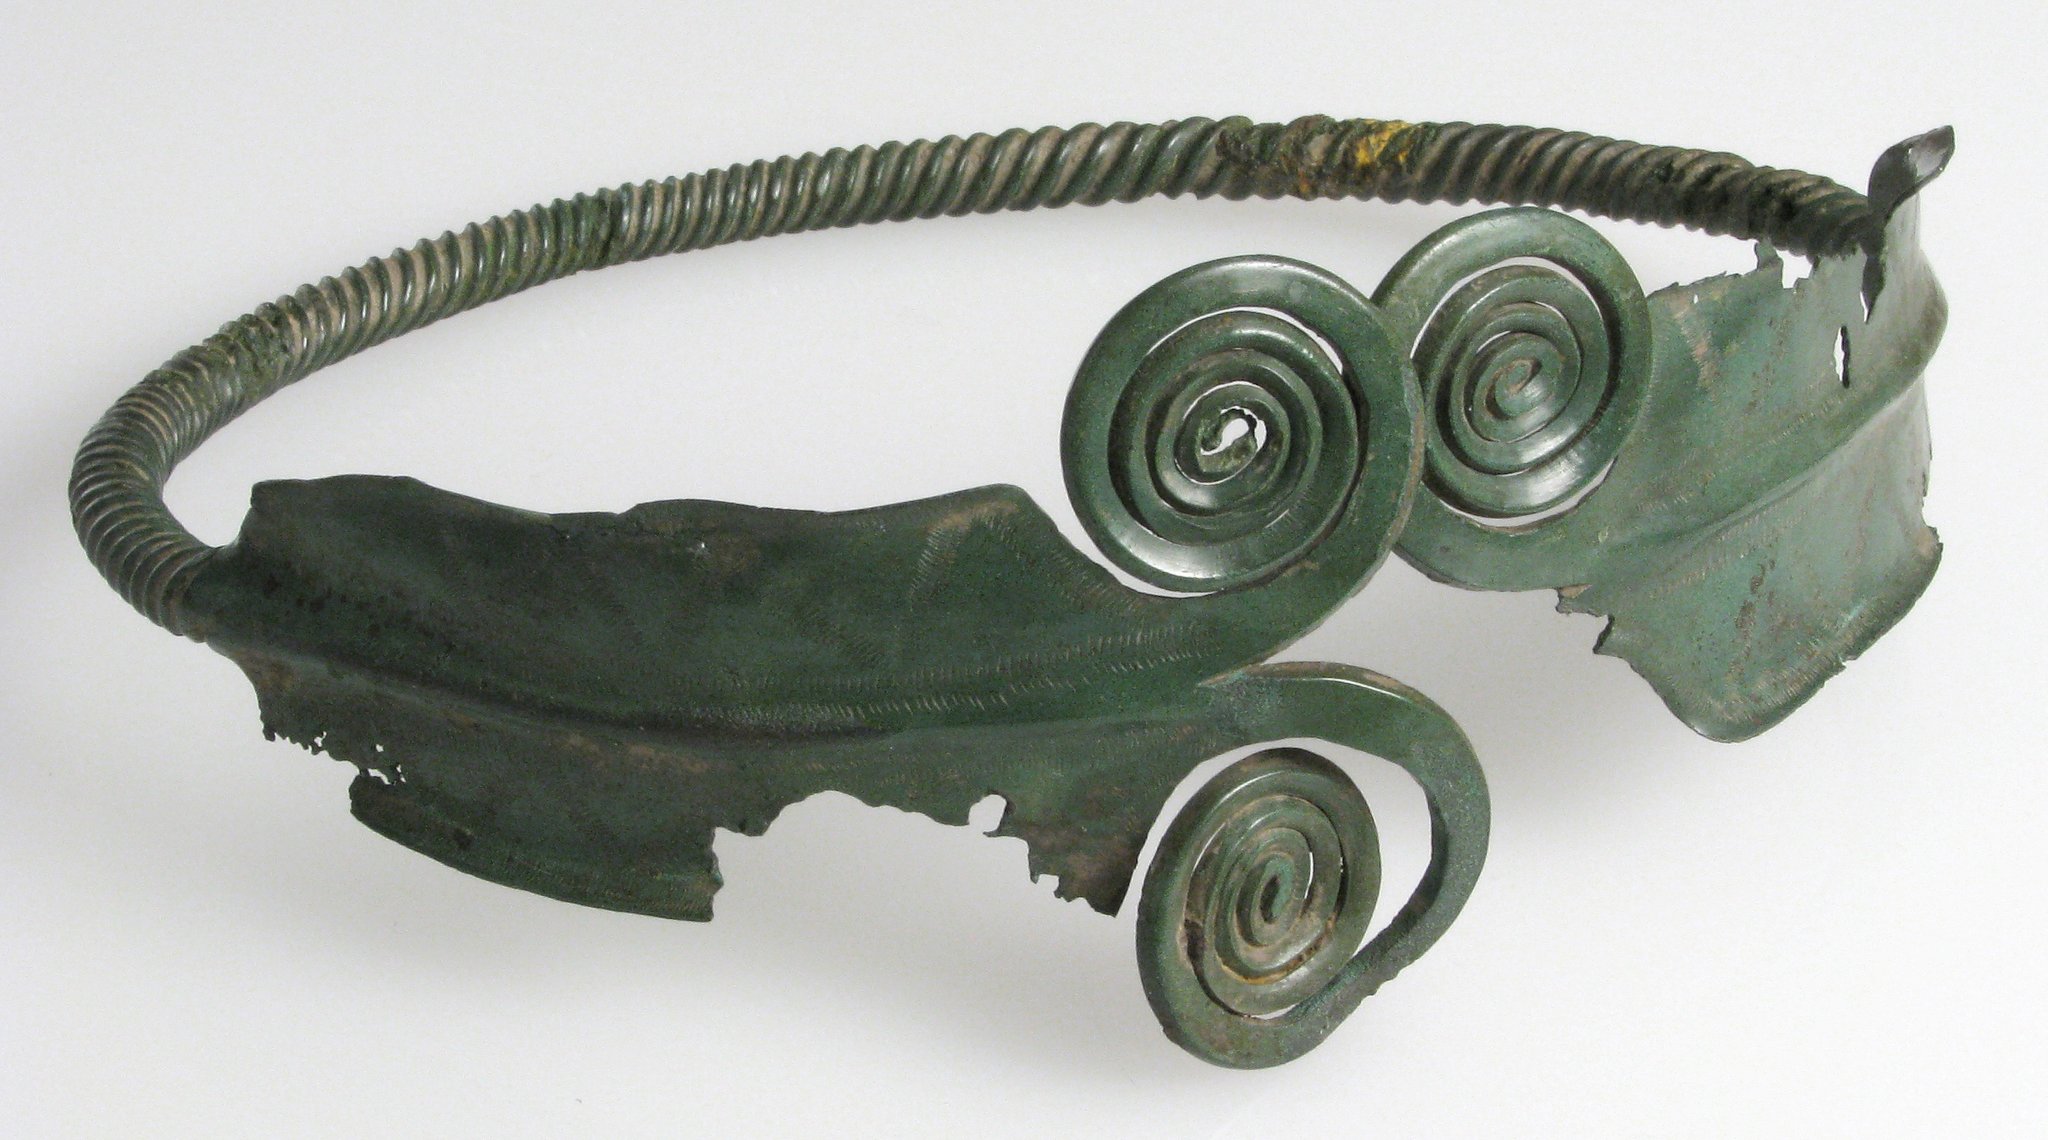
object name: diadem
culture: hallstatt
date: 1200-800 BCE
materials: copper alloy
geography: europe